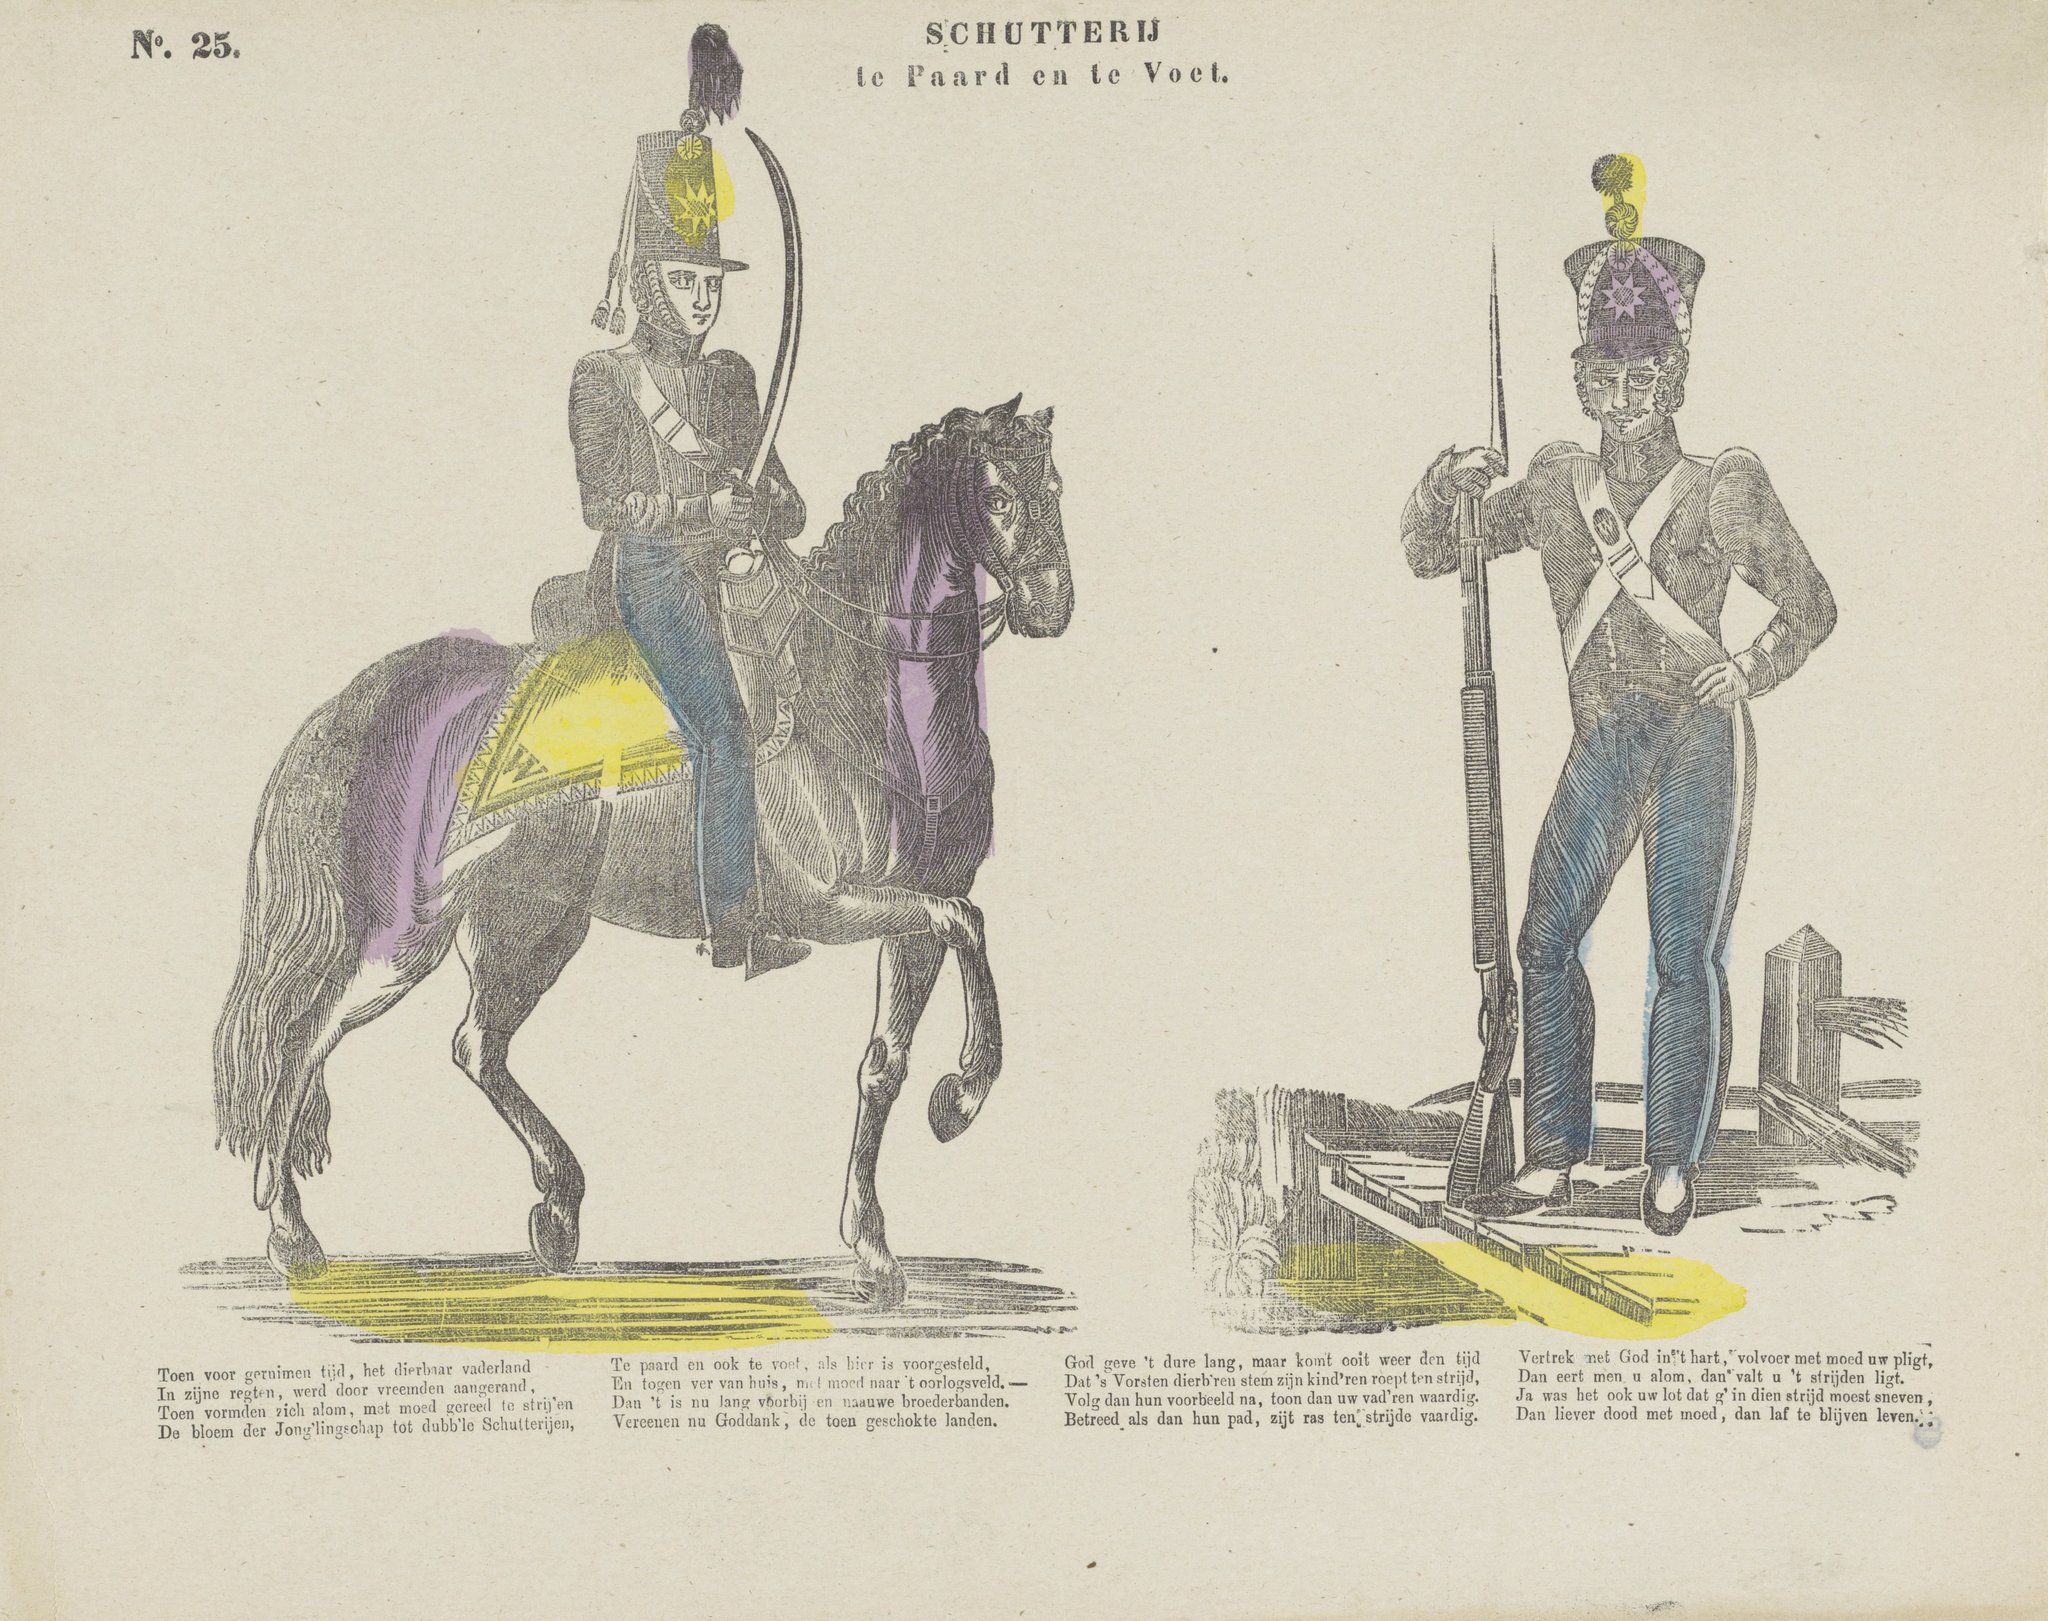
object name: popular print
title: Schutterij / te paard en te voet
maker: jacob coldewijn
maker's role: print maker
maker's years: 1796-1855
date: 1850-1870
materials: paper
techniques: colour, letterpress printing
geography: netherlands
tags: warfare; military affairs (+ cavalry, horsemen), the soldier; the soldier's life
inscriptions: collector's mark: Lugt 2760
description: Blad met 2 voorstellingen van Nederlandse militairen, één te paard en één te voet. Onder elke voorstelling een vers. Linksboven genummerd: No. 25.